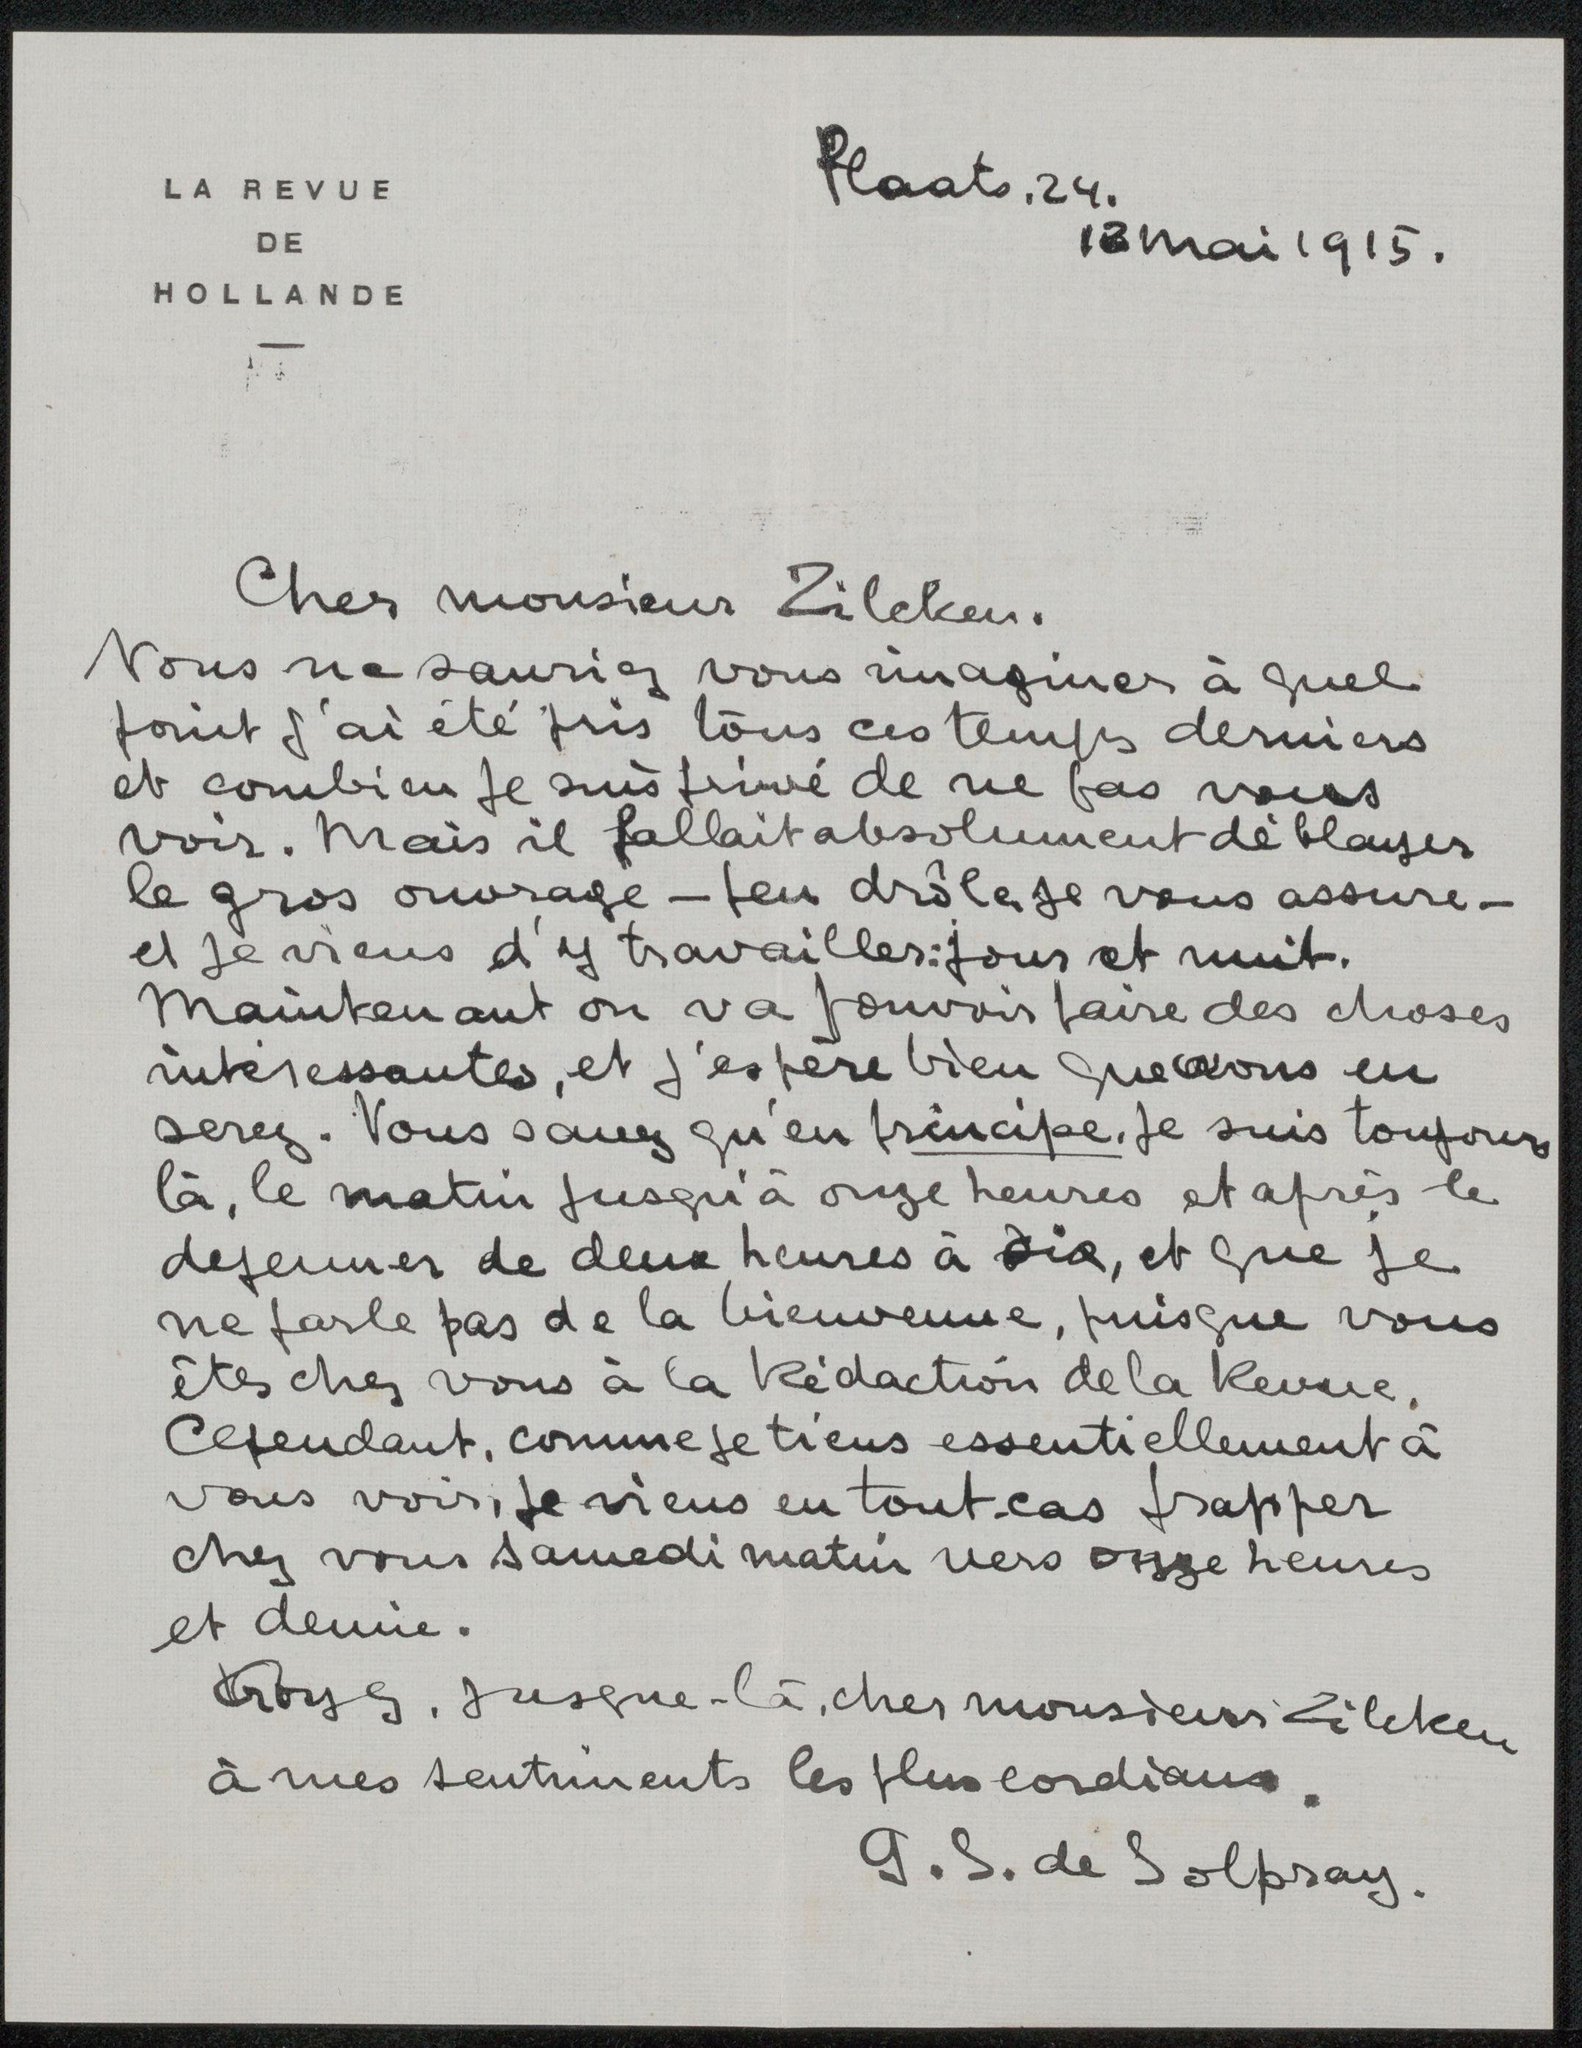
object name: letter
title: Brief aan Philip Zilcken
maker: georges de solpray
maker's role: schrijver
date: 1915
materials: ink, paper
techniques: pen, printing, writing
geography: the hague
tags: the hague, painter, draughtsman, philip zilcken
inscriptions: collector's mark: ‘RPK’, watermark